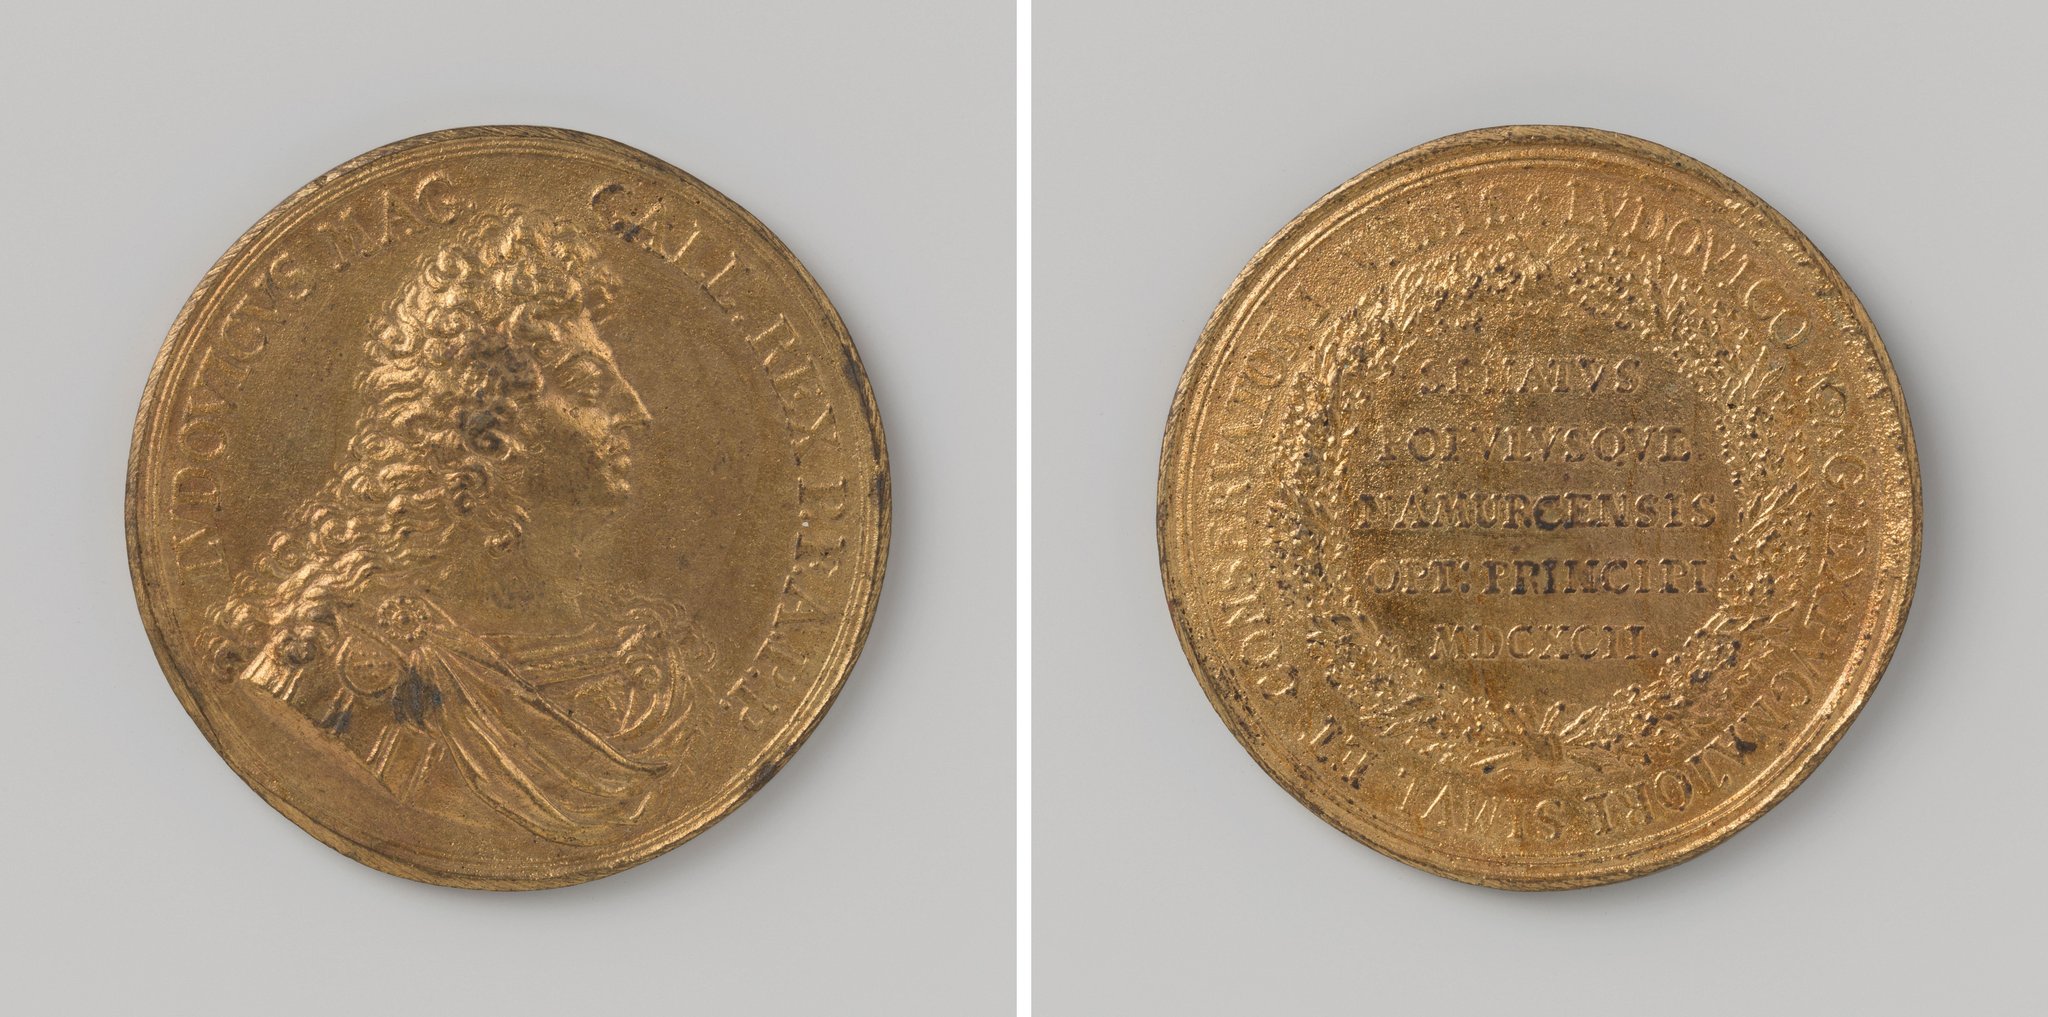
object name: history medal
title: Inname van Namen door de Fransen, ter ere van Lodewijk XIV, penning geslagen door raad en volk van die stad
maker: Anonymous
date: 1692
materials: bronze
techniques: striking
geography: namur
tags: lodewijk xiv (koning van frankrijk)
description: Bronzen penning. Voorzijde: borststuk man binnen omschrift. Keerzijde: opschrift binnen krans en omschrift